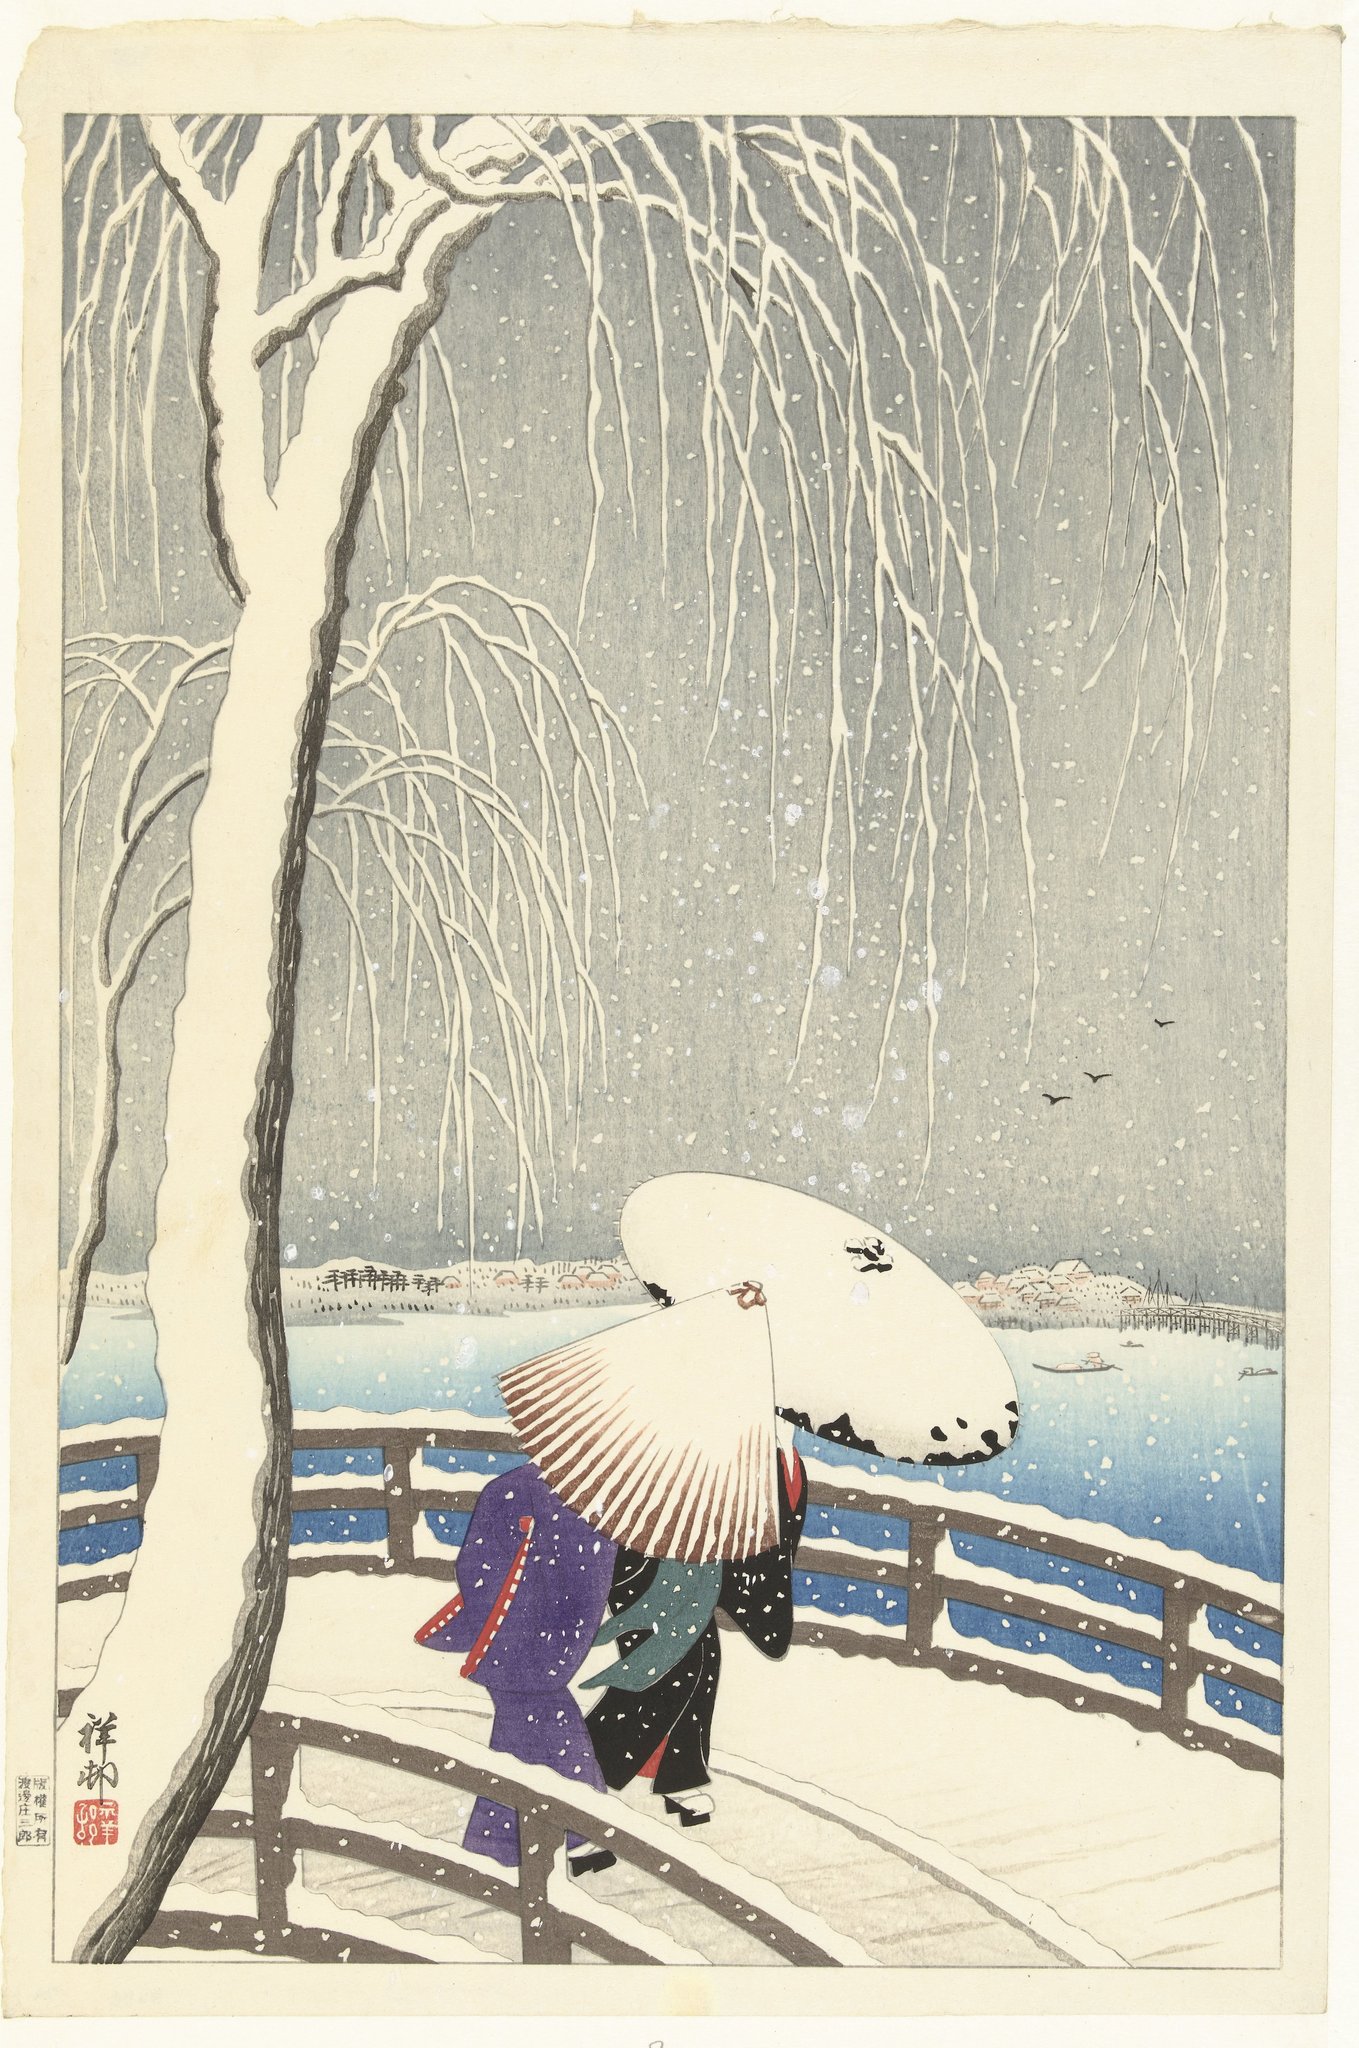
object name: print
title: In de sneeuw op Yanagibashi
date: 1927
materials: calcium oxide, paper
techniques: blind stamped, woodcut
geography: tokyo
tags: umbrella, snow, landscapes (+ landscape with figures, staffage)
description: Sneeuwlandschap; twee vrouwen onder paraplu`s lopend over een brug waarnaast treurwilgen. Yanagibashi betekent Wilgenbrug.